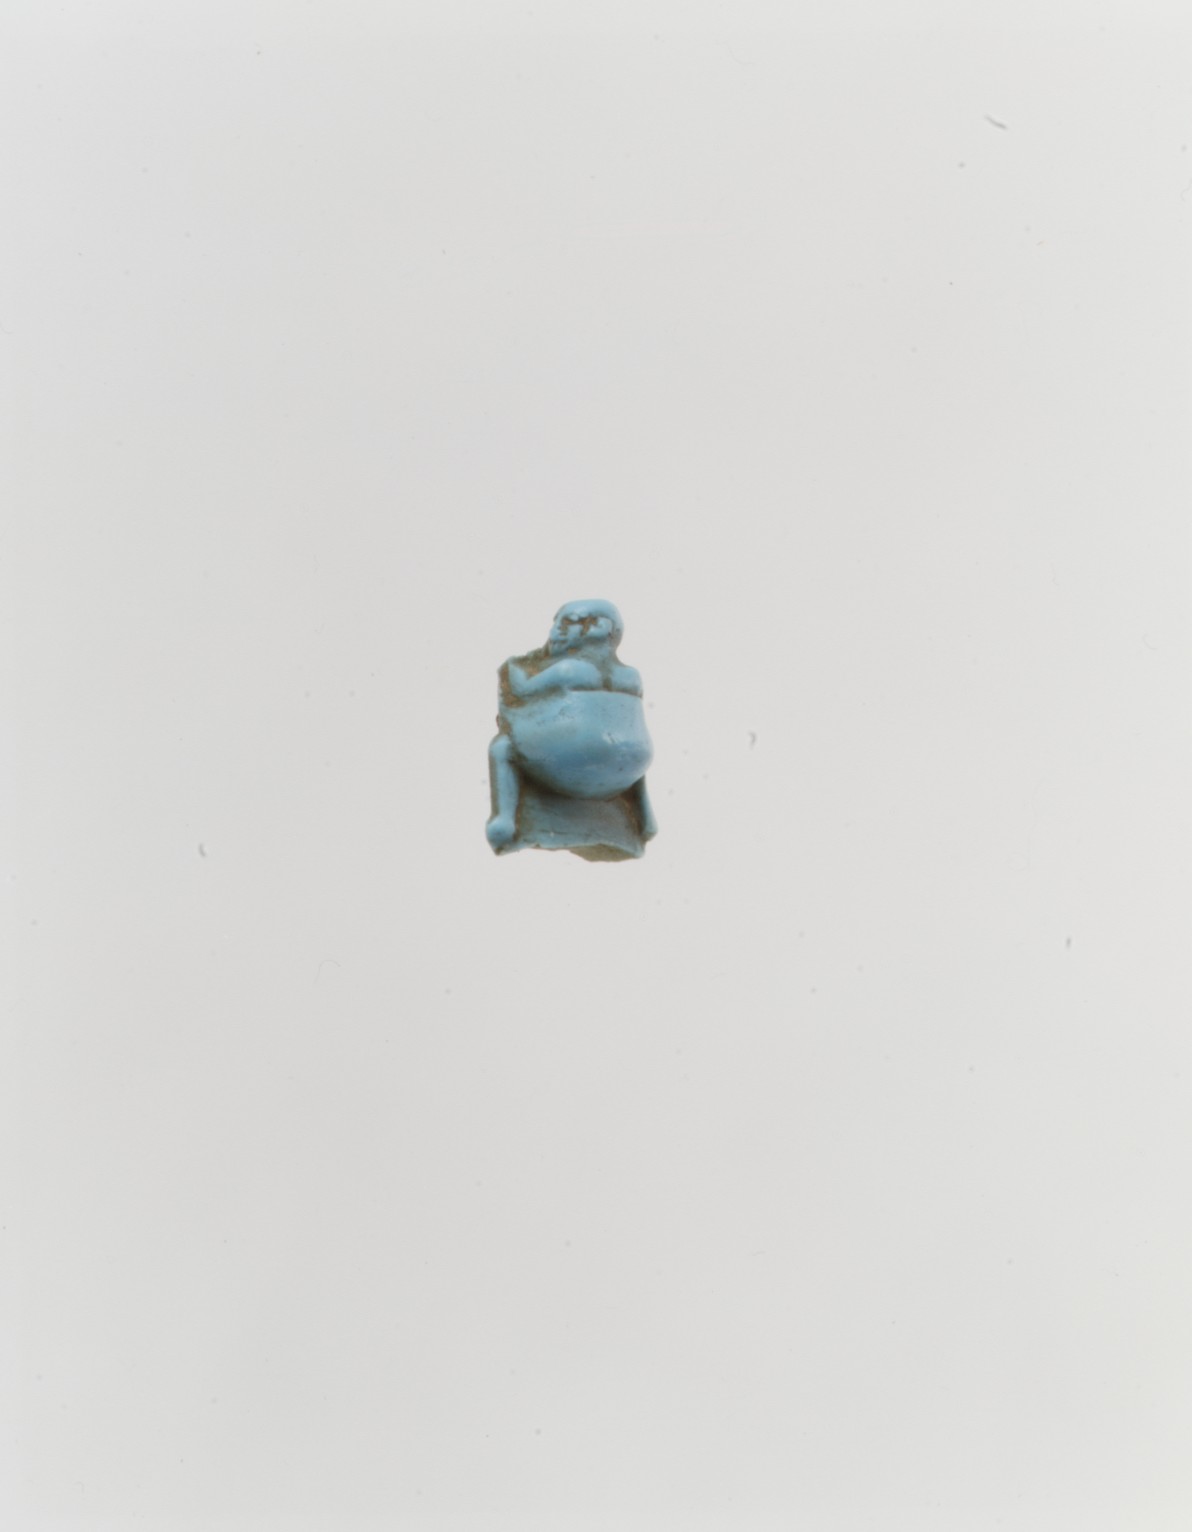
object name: vase fragment, child in a sling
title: Small Child in a Sling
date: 1427-1295 BCE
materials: faience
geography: egypt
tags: children